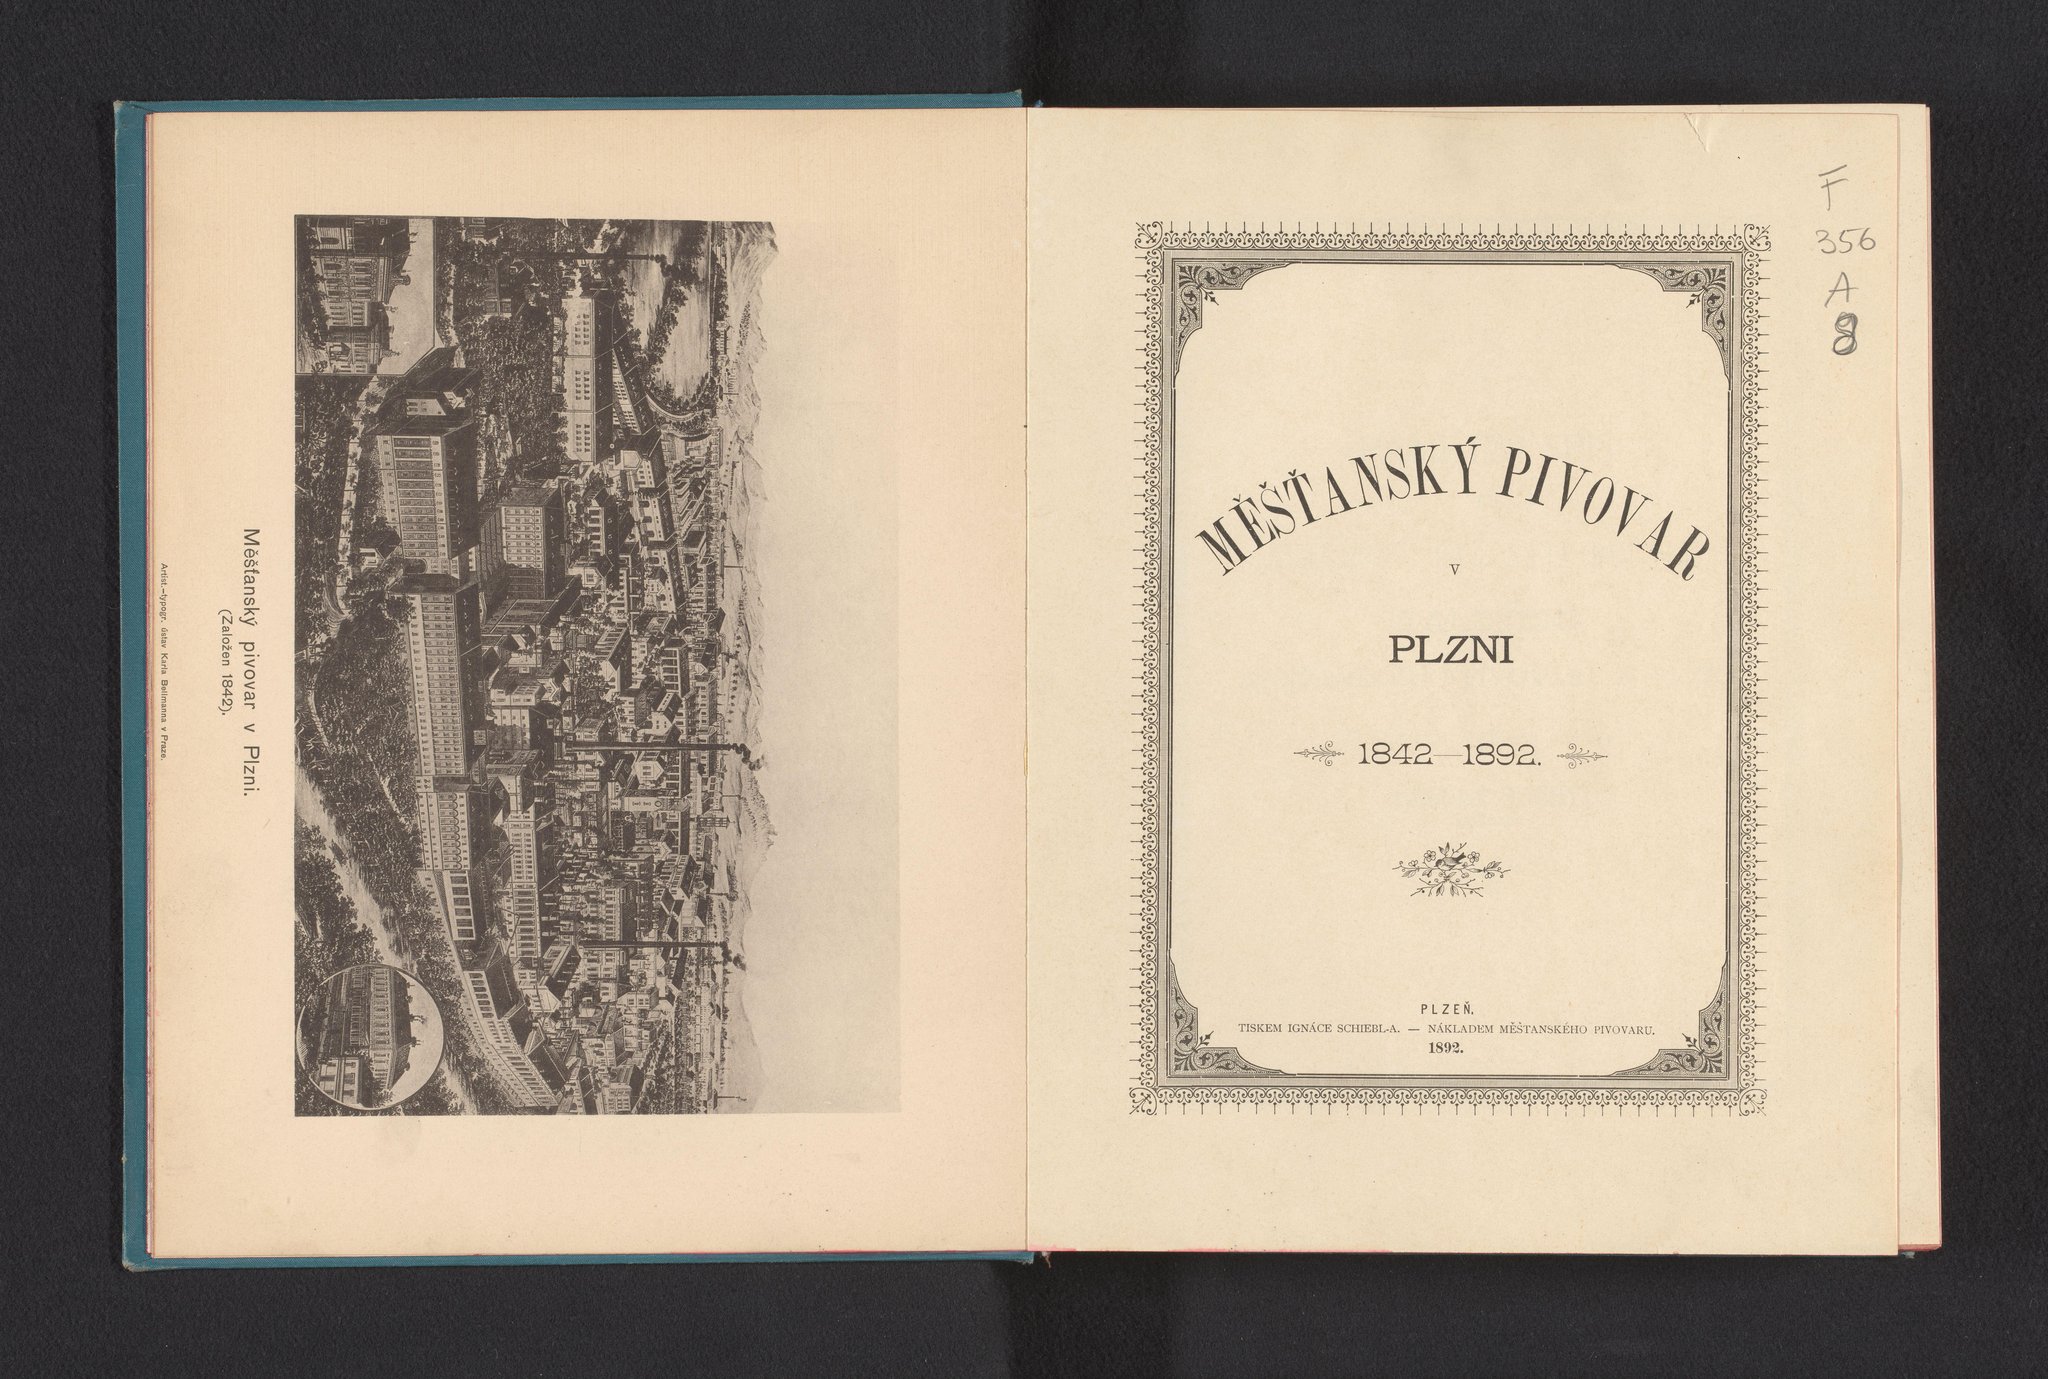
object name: page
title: Mĕšťanský pivovar v Plzni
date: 1882-1892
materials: paper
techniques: photograph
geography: prague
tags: brewer, city-view in general; 'veduta'